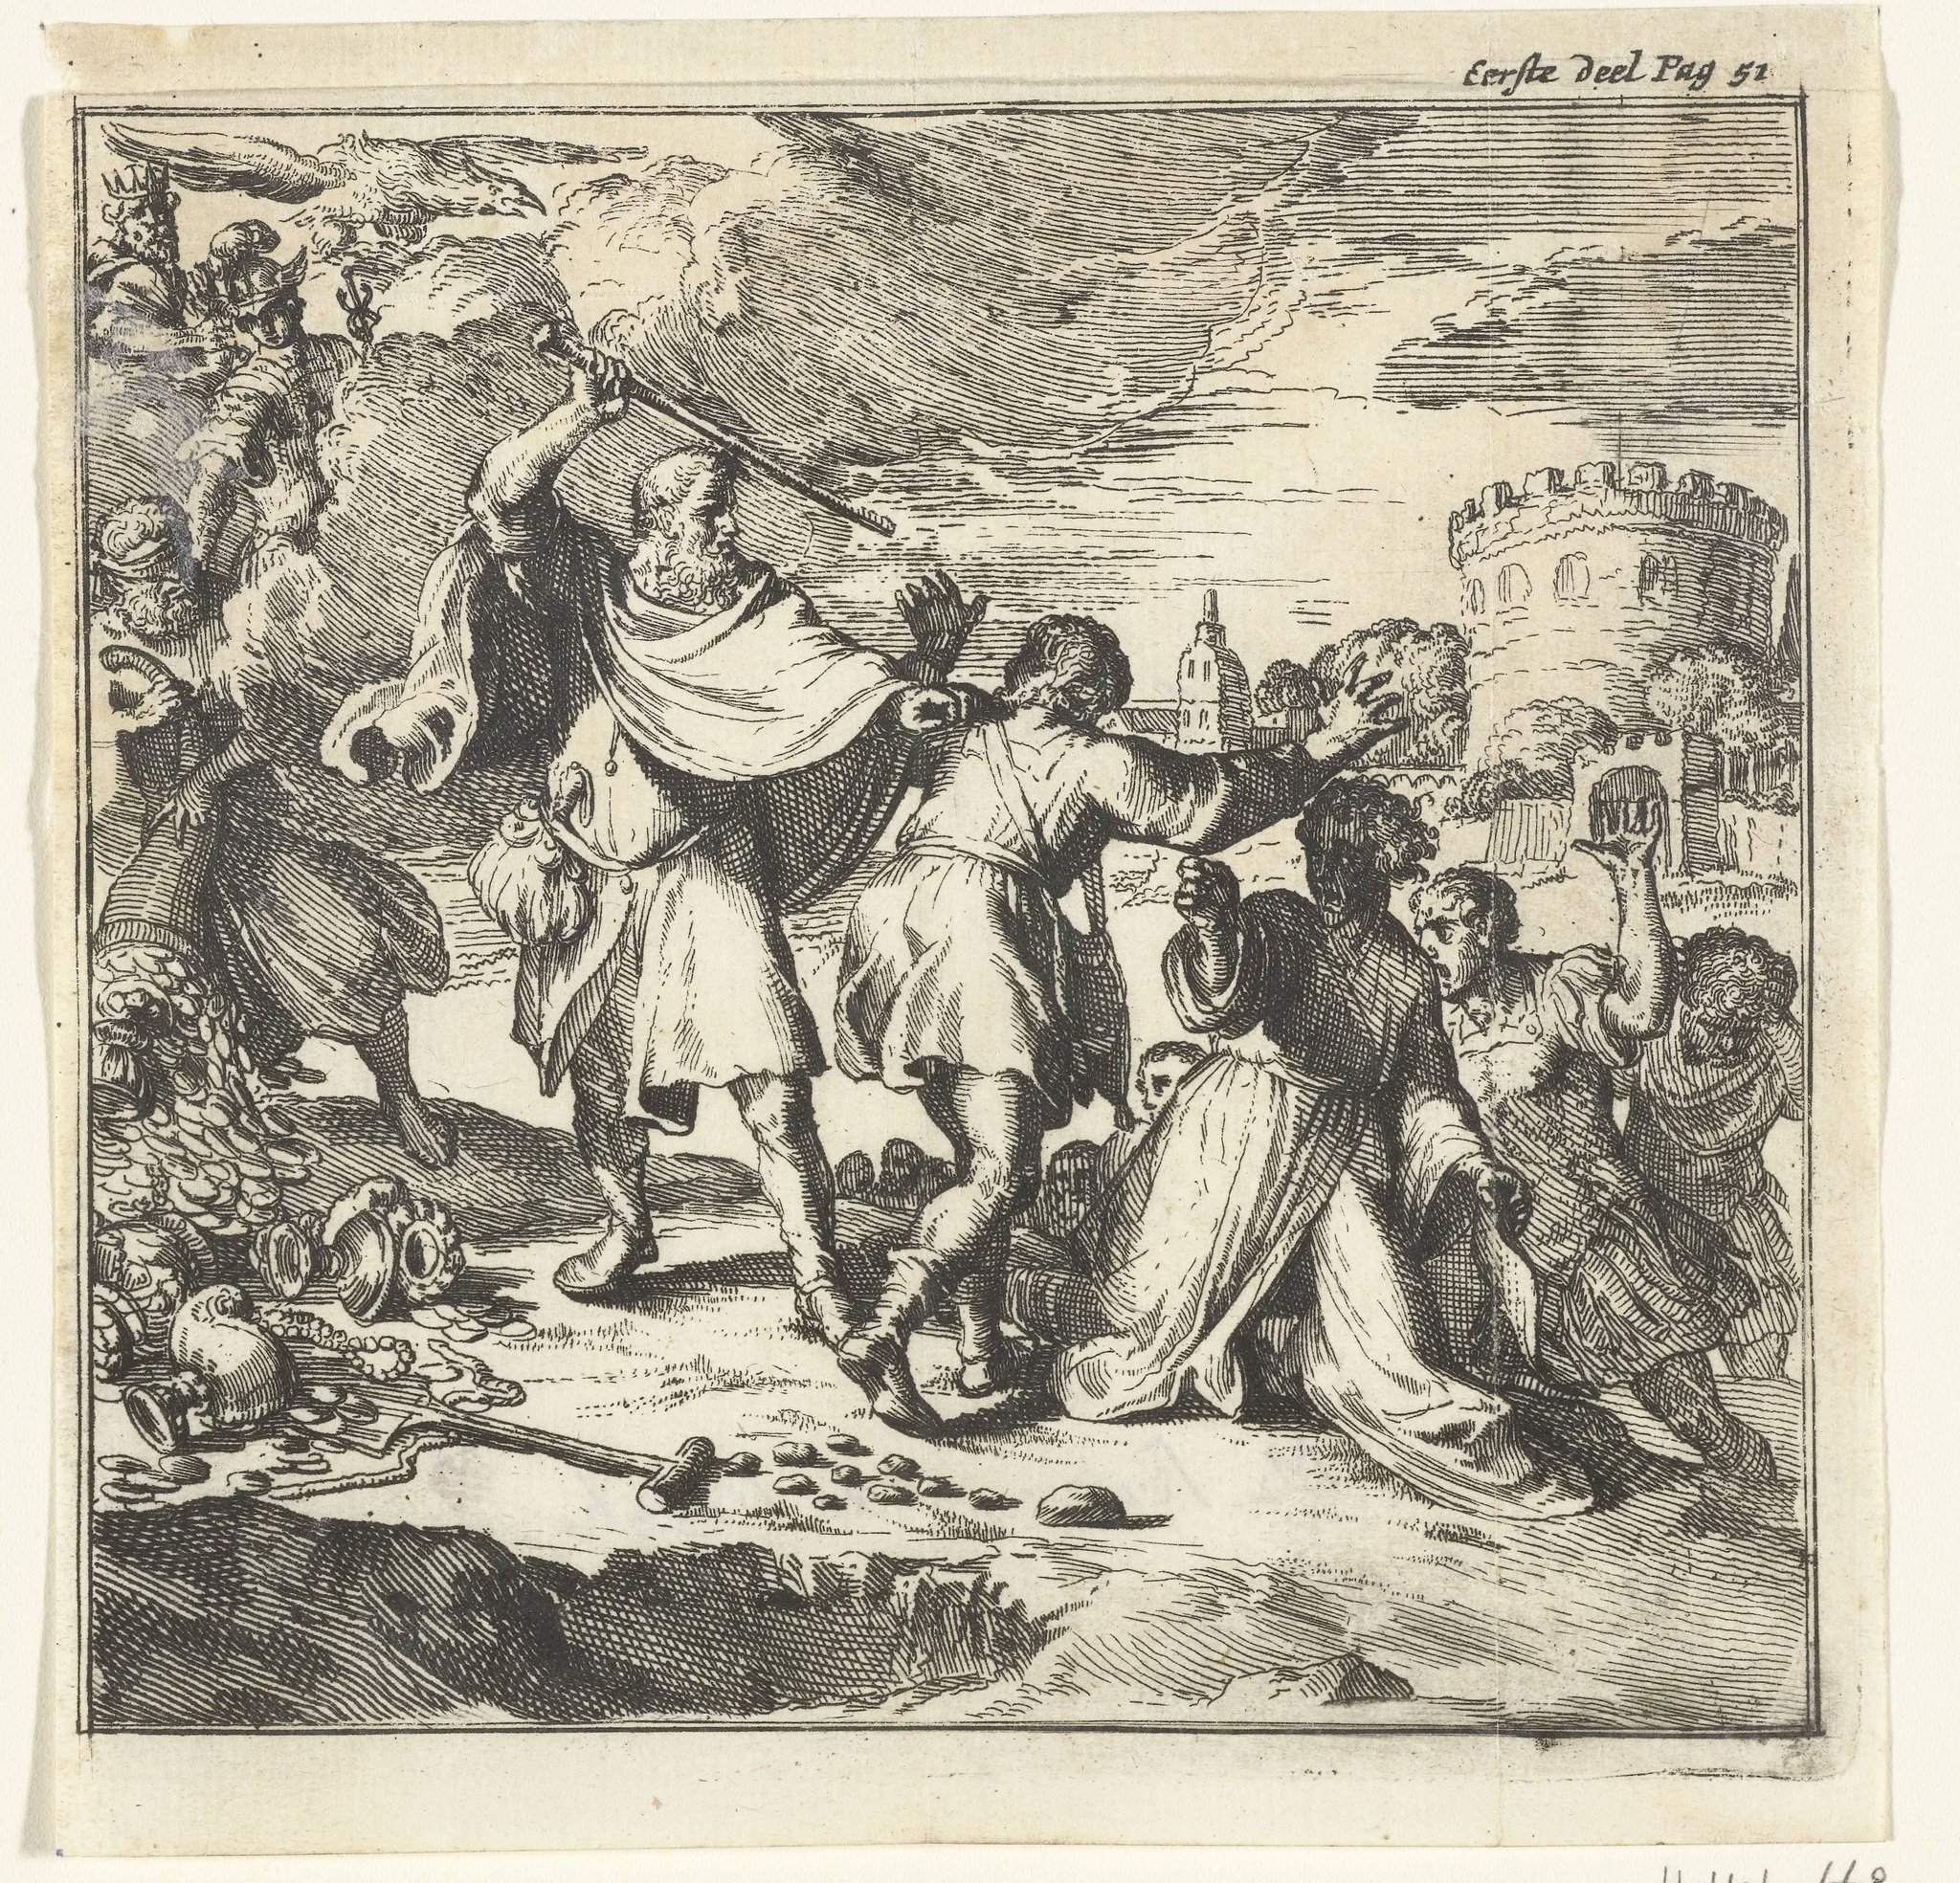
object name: print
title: Illustratie voor 'Alle de werken' van Lucianus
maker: romeyn de hooghe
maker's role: draughtsman, goldsmith, painter, print maker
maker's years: 1645-1708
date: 1679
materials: paper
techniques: etching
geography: amsterdam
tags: 'cornucopia', horn of plenty, (story of) mercury (hermes), (story of) jupiter (zeus)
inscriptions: collector's mark: Lugt 2760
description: Een man met een staf jaagt een groep boze mensen weg van een plaats waar allerlei schatten (o.a. muntstukken uit een hoorn des overvloeds) liggen uitgestald. Links op de achtergrond Jupiter met zijn adelaar en Mercurius, die toekijken vanuit de wolken.